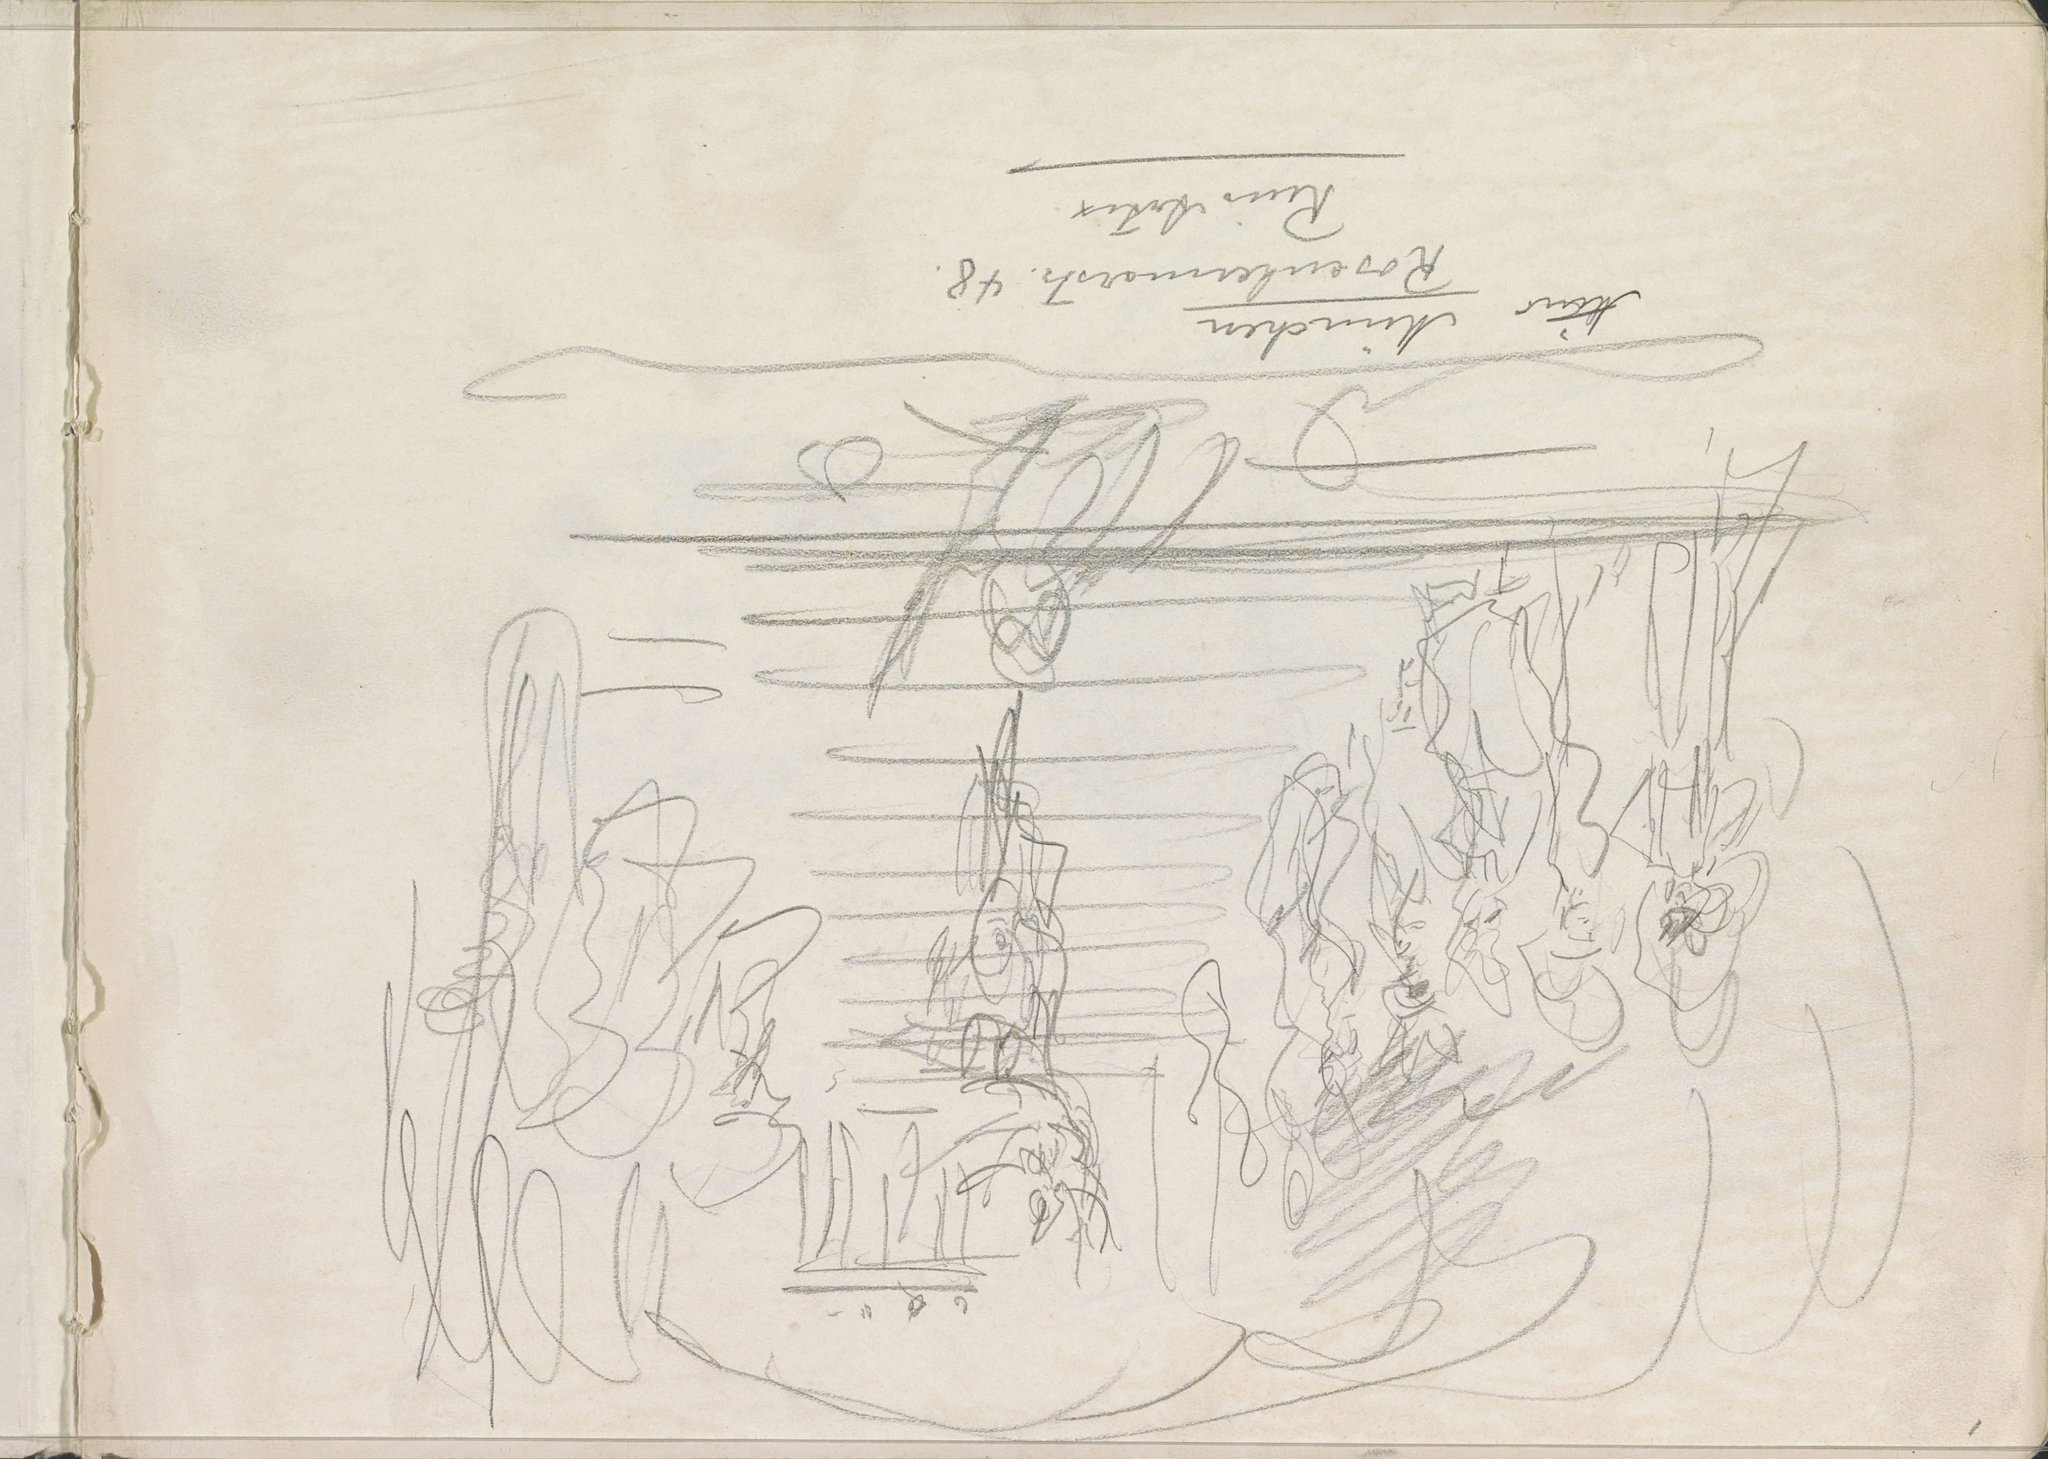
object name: sketchbook leaf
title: Artiesten op het toneel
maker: isaac israels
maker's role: draughtsman, painter, print maker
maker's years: 1865-1934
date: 1875-1934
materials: paper, pencil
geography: the hague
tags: monocycle, ballet group; dancers on the stage, vaudeville, variety-show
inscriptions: annotation: ‘München / Rosenheimerstr. 48 / R[...] Artix’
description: Links en rechts mogelijk danseressen. In het midden een acrobaat op een eenwieler. Vooraan mogelijk de dirigent in een orkestbak. Blad 1 recto uit schetsboek V met 33 bladen.